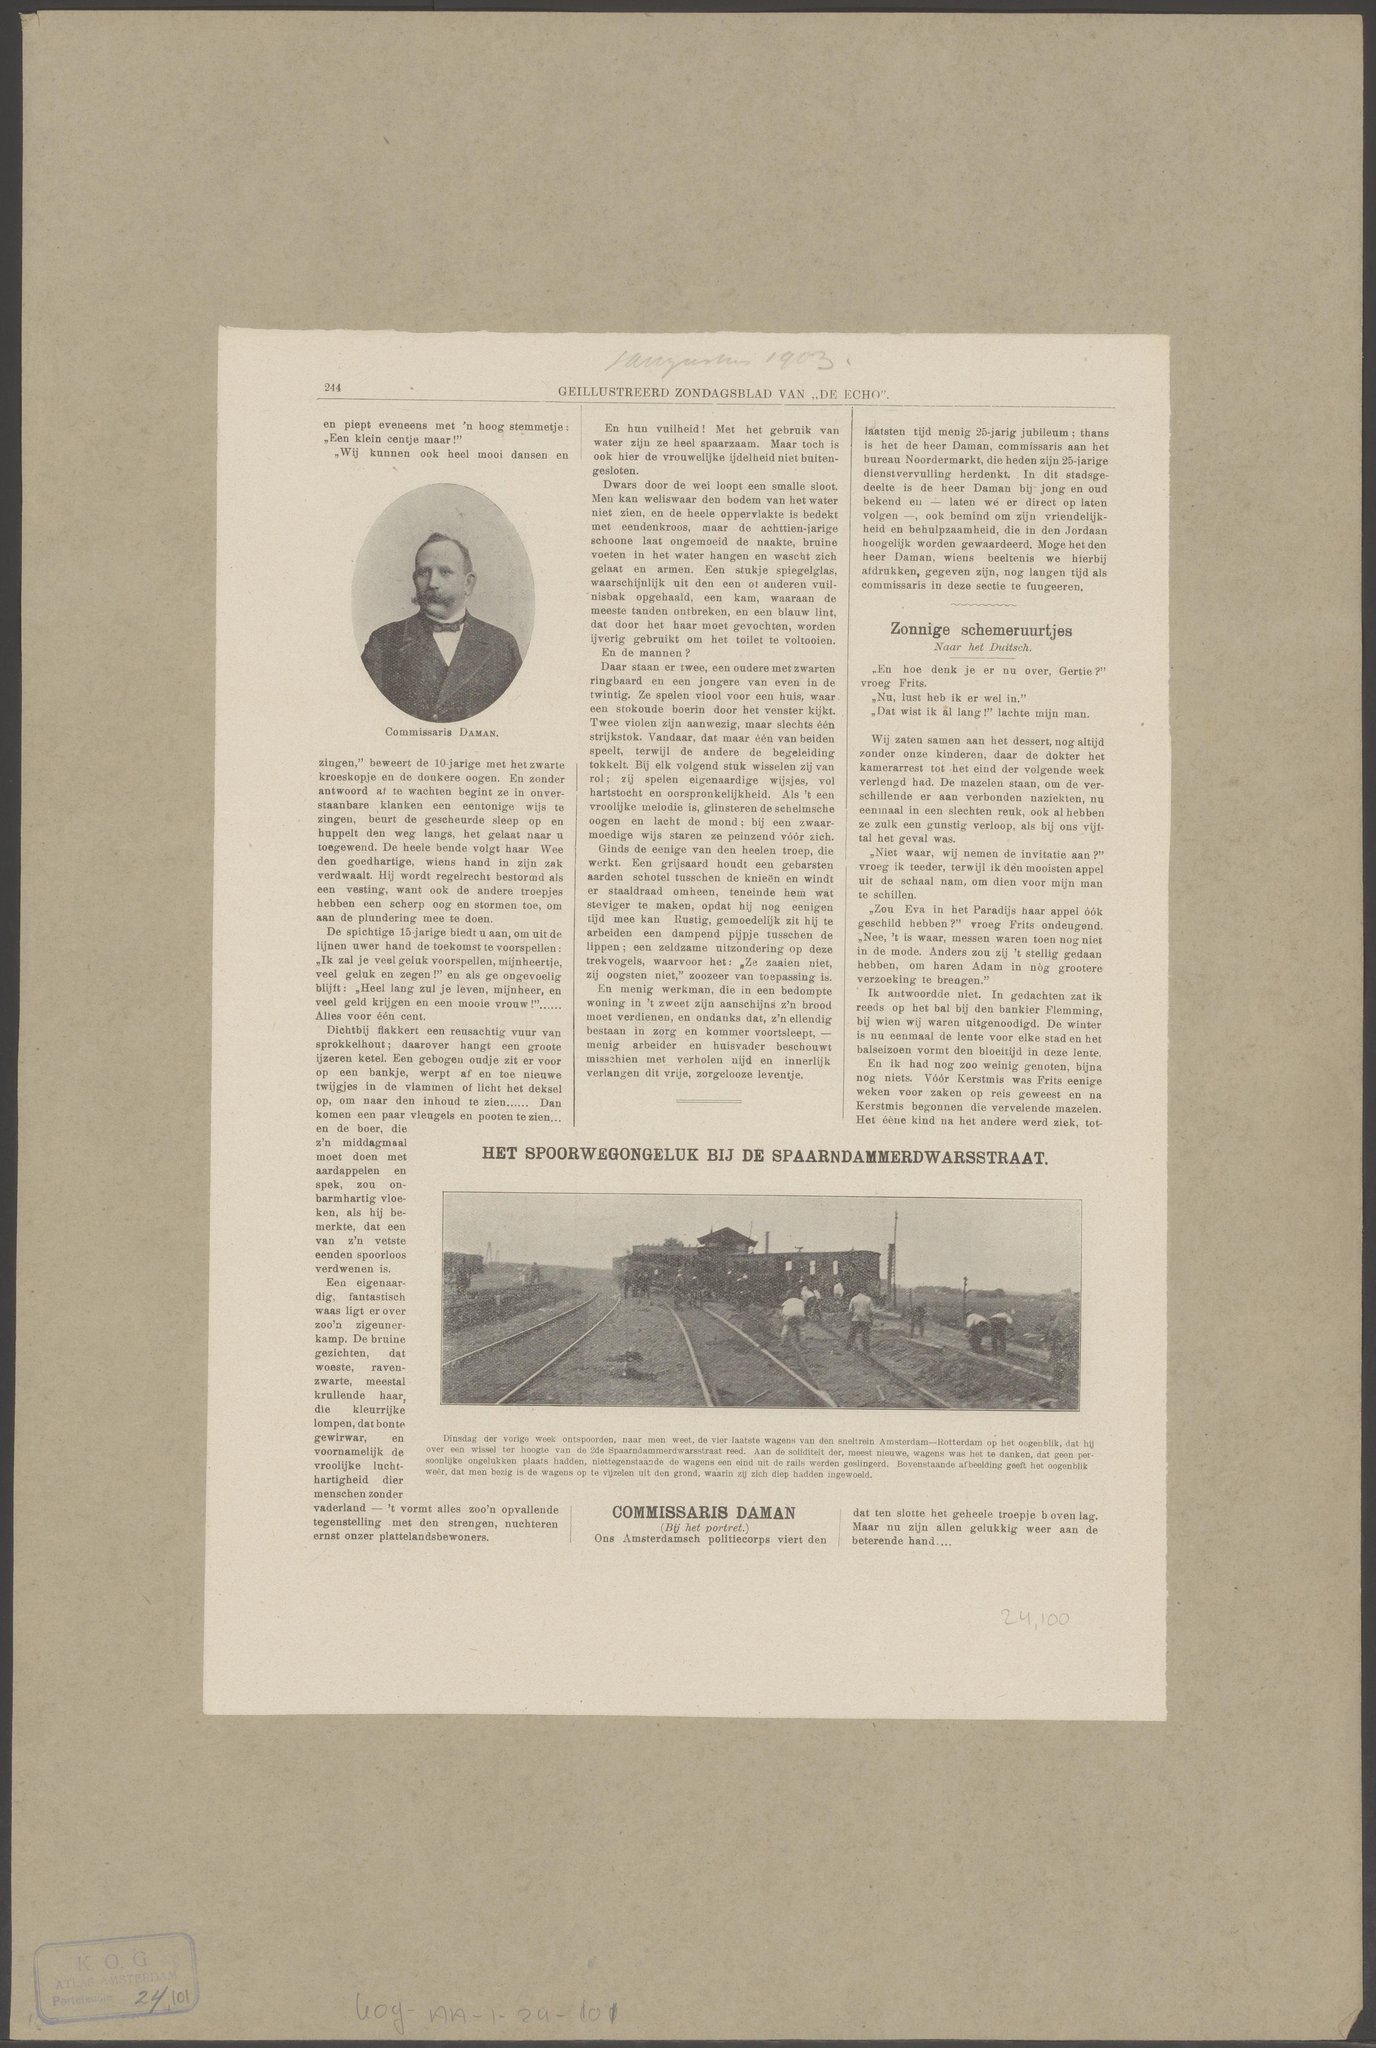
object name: photomechanical print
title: Portret van Johannes Bernardus Daman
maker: Anonymous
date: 1903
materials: paper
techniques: letterpress printing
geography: netherlands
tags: amsterdam, historical persons, police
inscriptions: collector's mark: Lugt 1641b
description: Op hetzelfde object staat ook een fotomechanische afdruk van een spoorwegongeluk dat plaatsvond op dinsdag 21 of dinsdag 28 juli 1903 ter hoogte van de Tweede Spaarndammerdwarsstraat te Amsterdam. Onderwerpsrubriek binnen de Atlas Amsterdam: Politie.